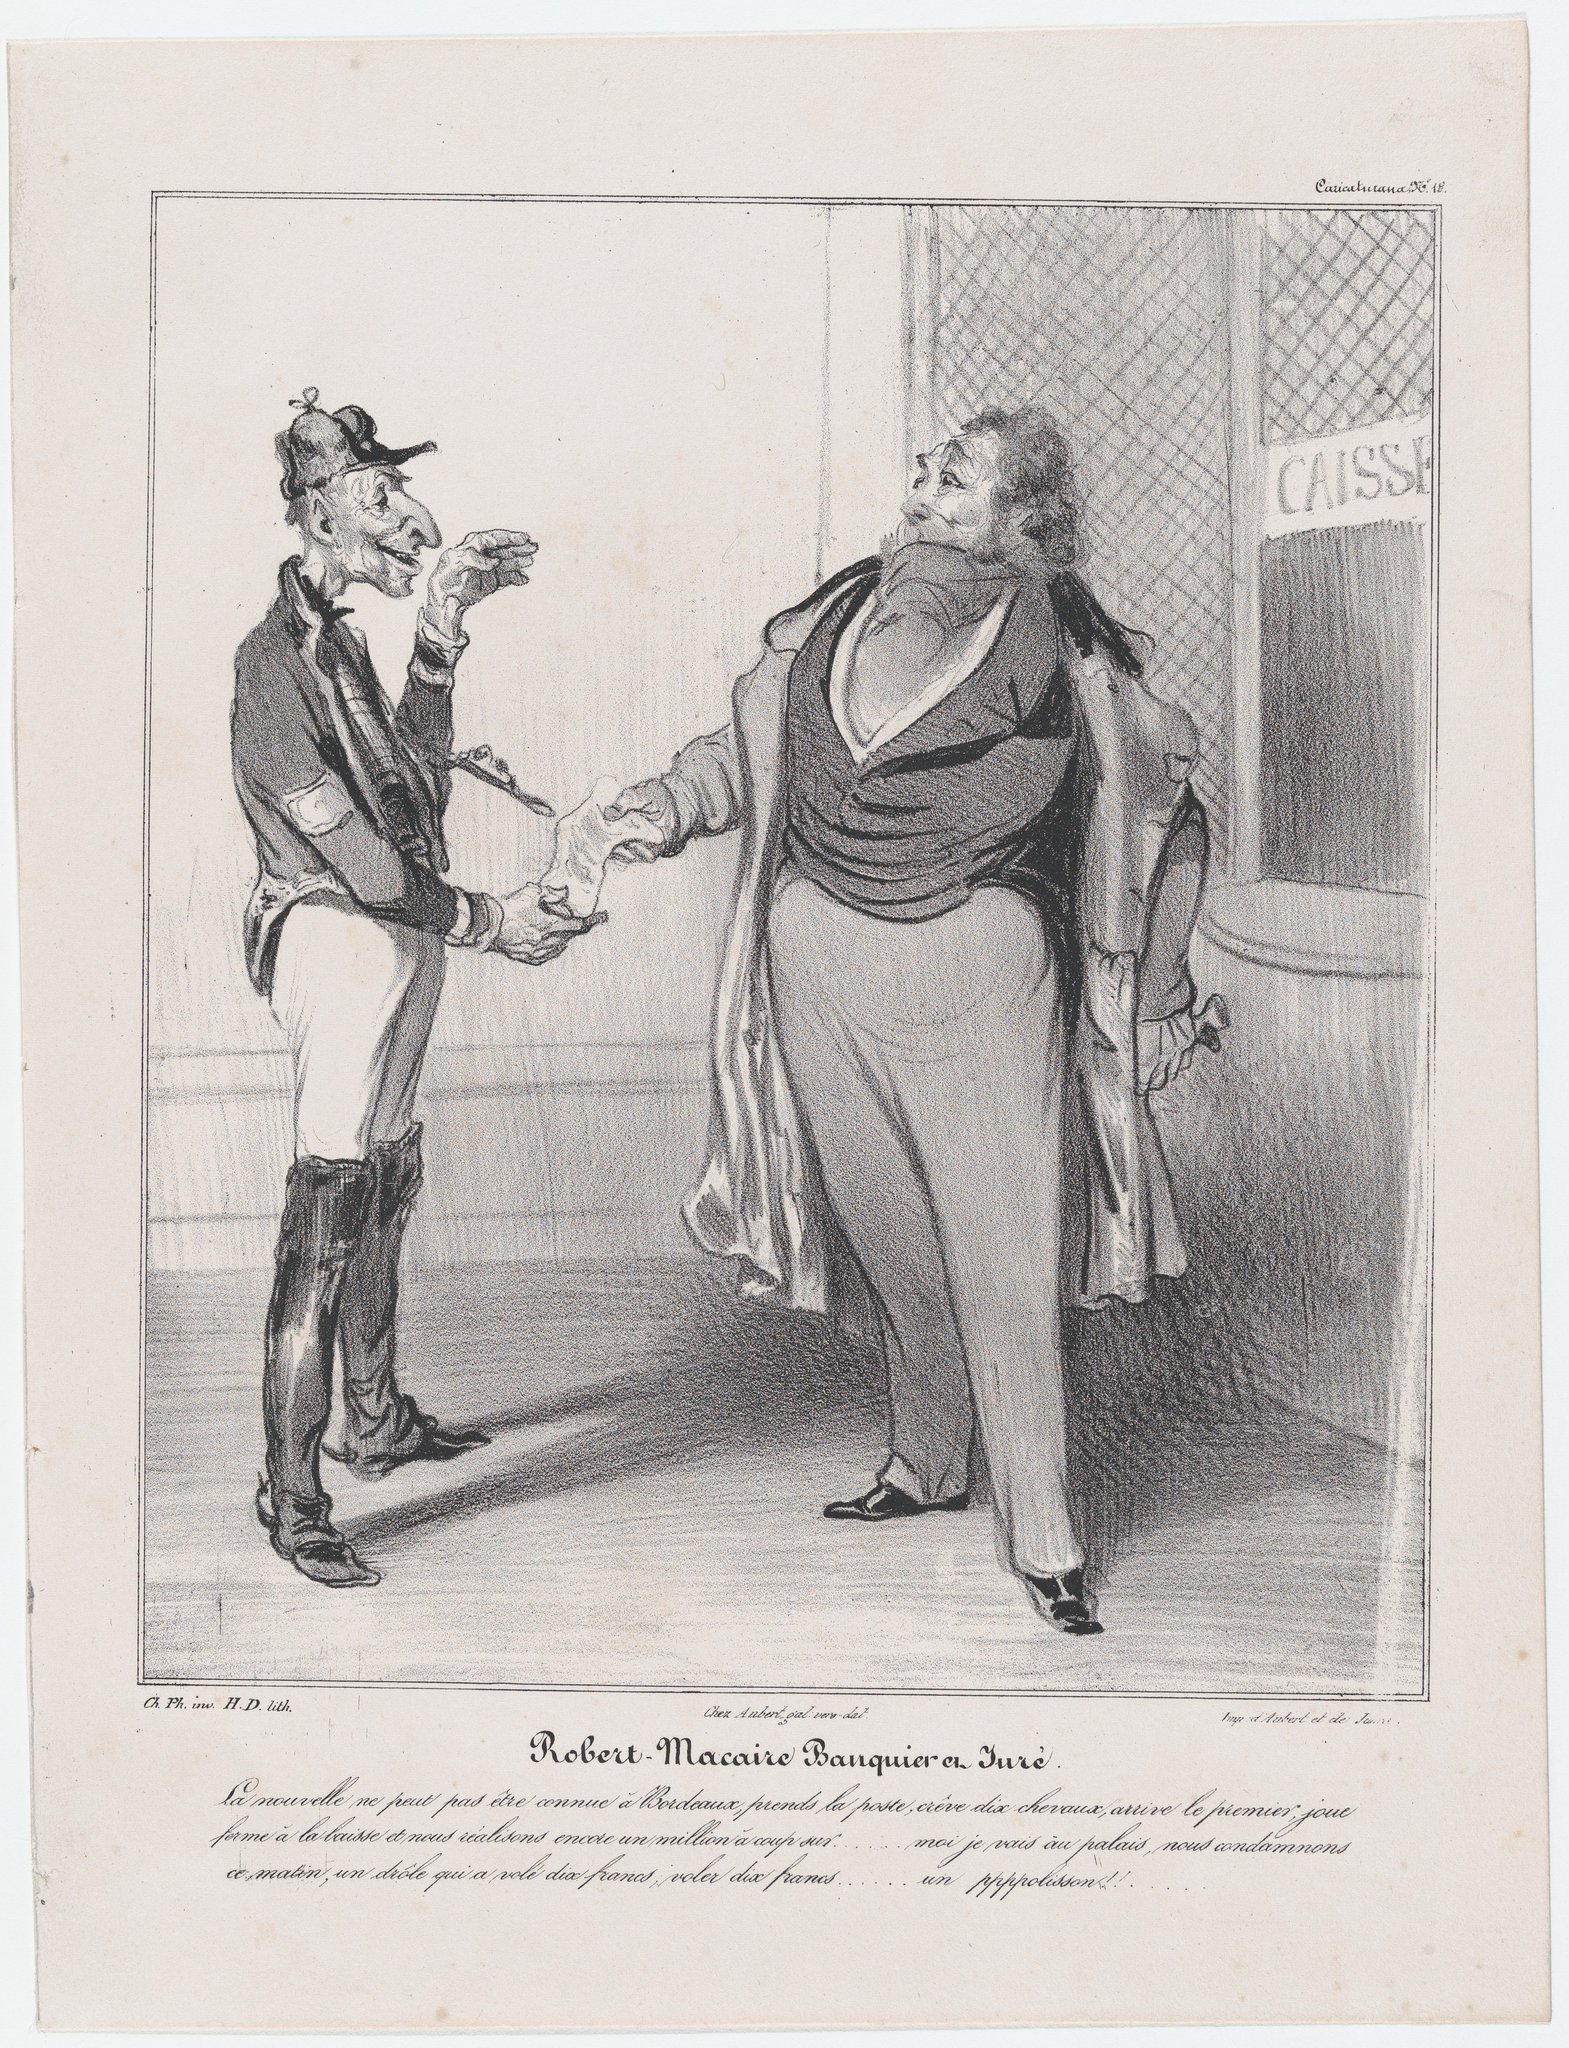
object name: print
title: Plate 18: Robert Macaire, banker and juror, from 'Caricaturana,' published in Les Robert Macaires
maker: honoré daumier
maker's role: artist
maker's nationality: french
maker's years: 1808-1879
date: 1838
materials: paper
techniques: lithograph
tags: satire,men